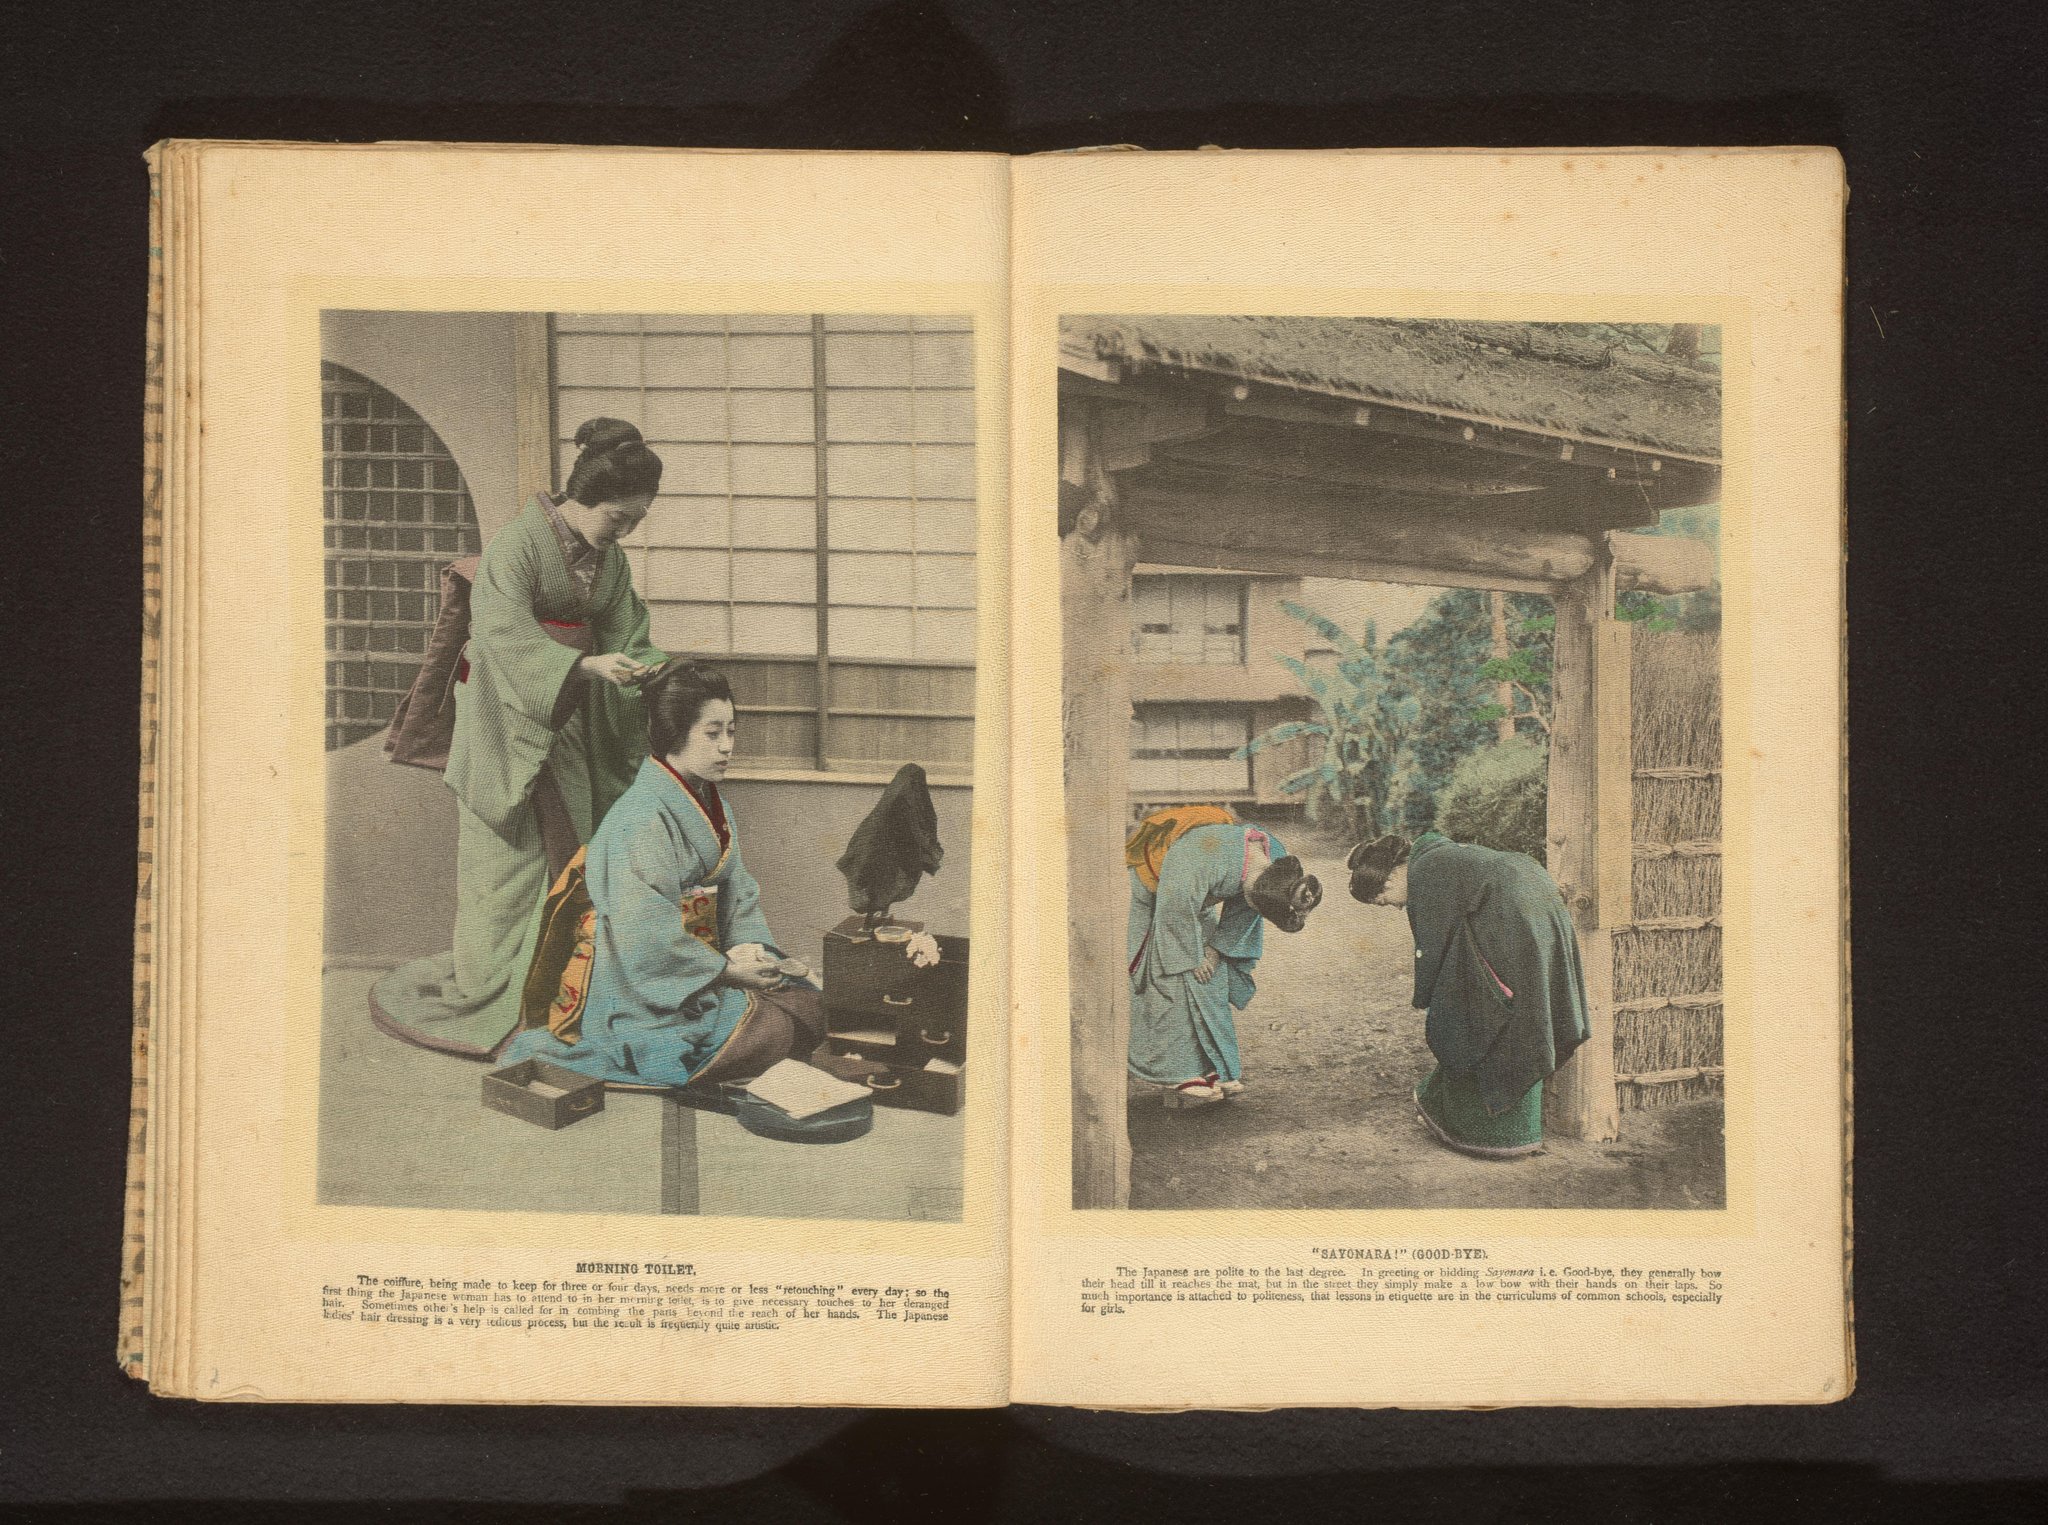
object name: photomechanical print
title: Morning toilet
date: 1886-1896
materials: paper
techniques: photograph, hand coloring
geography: japan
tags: making toilet, adult woman, interior ~ representation of a building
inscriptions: inscription: ‘The coiffure (...) frequently quite artistic.’